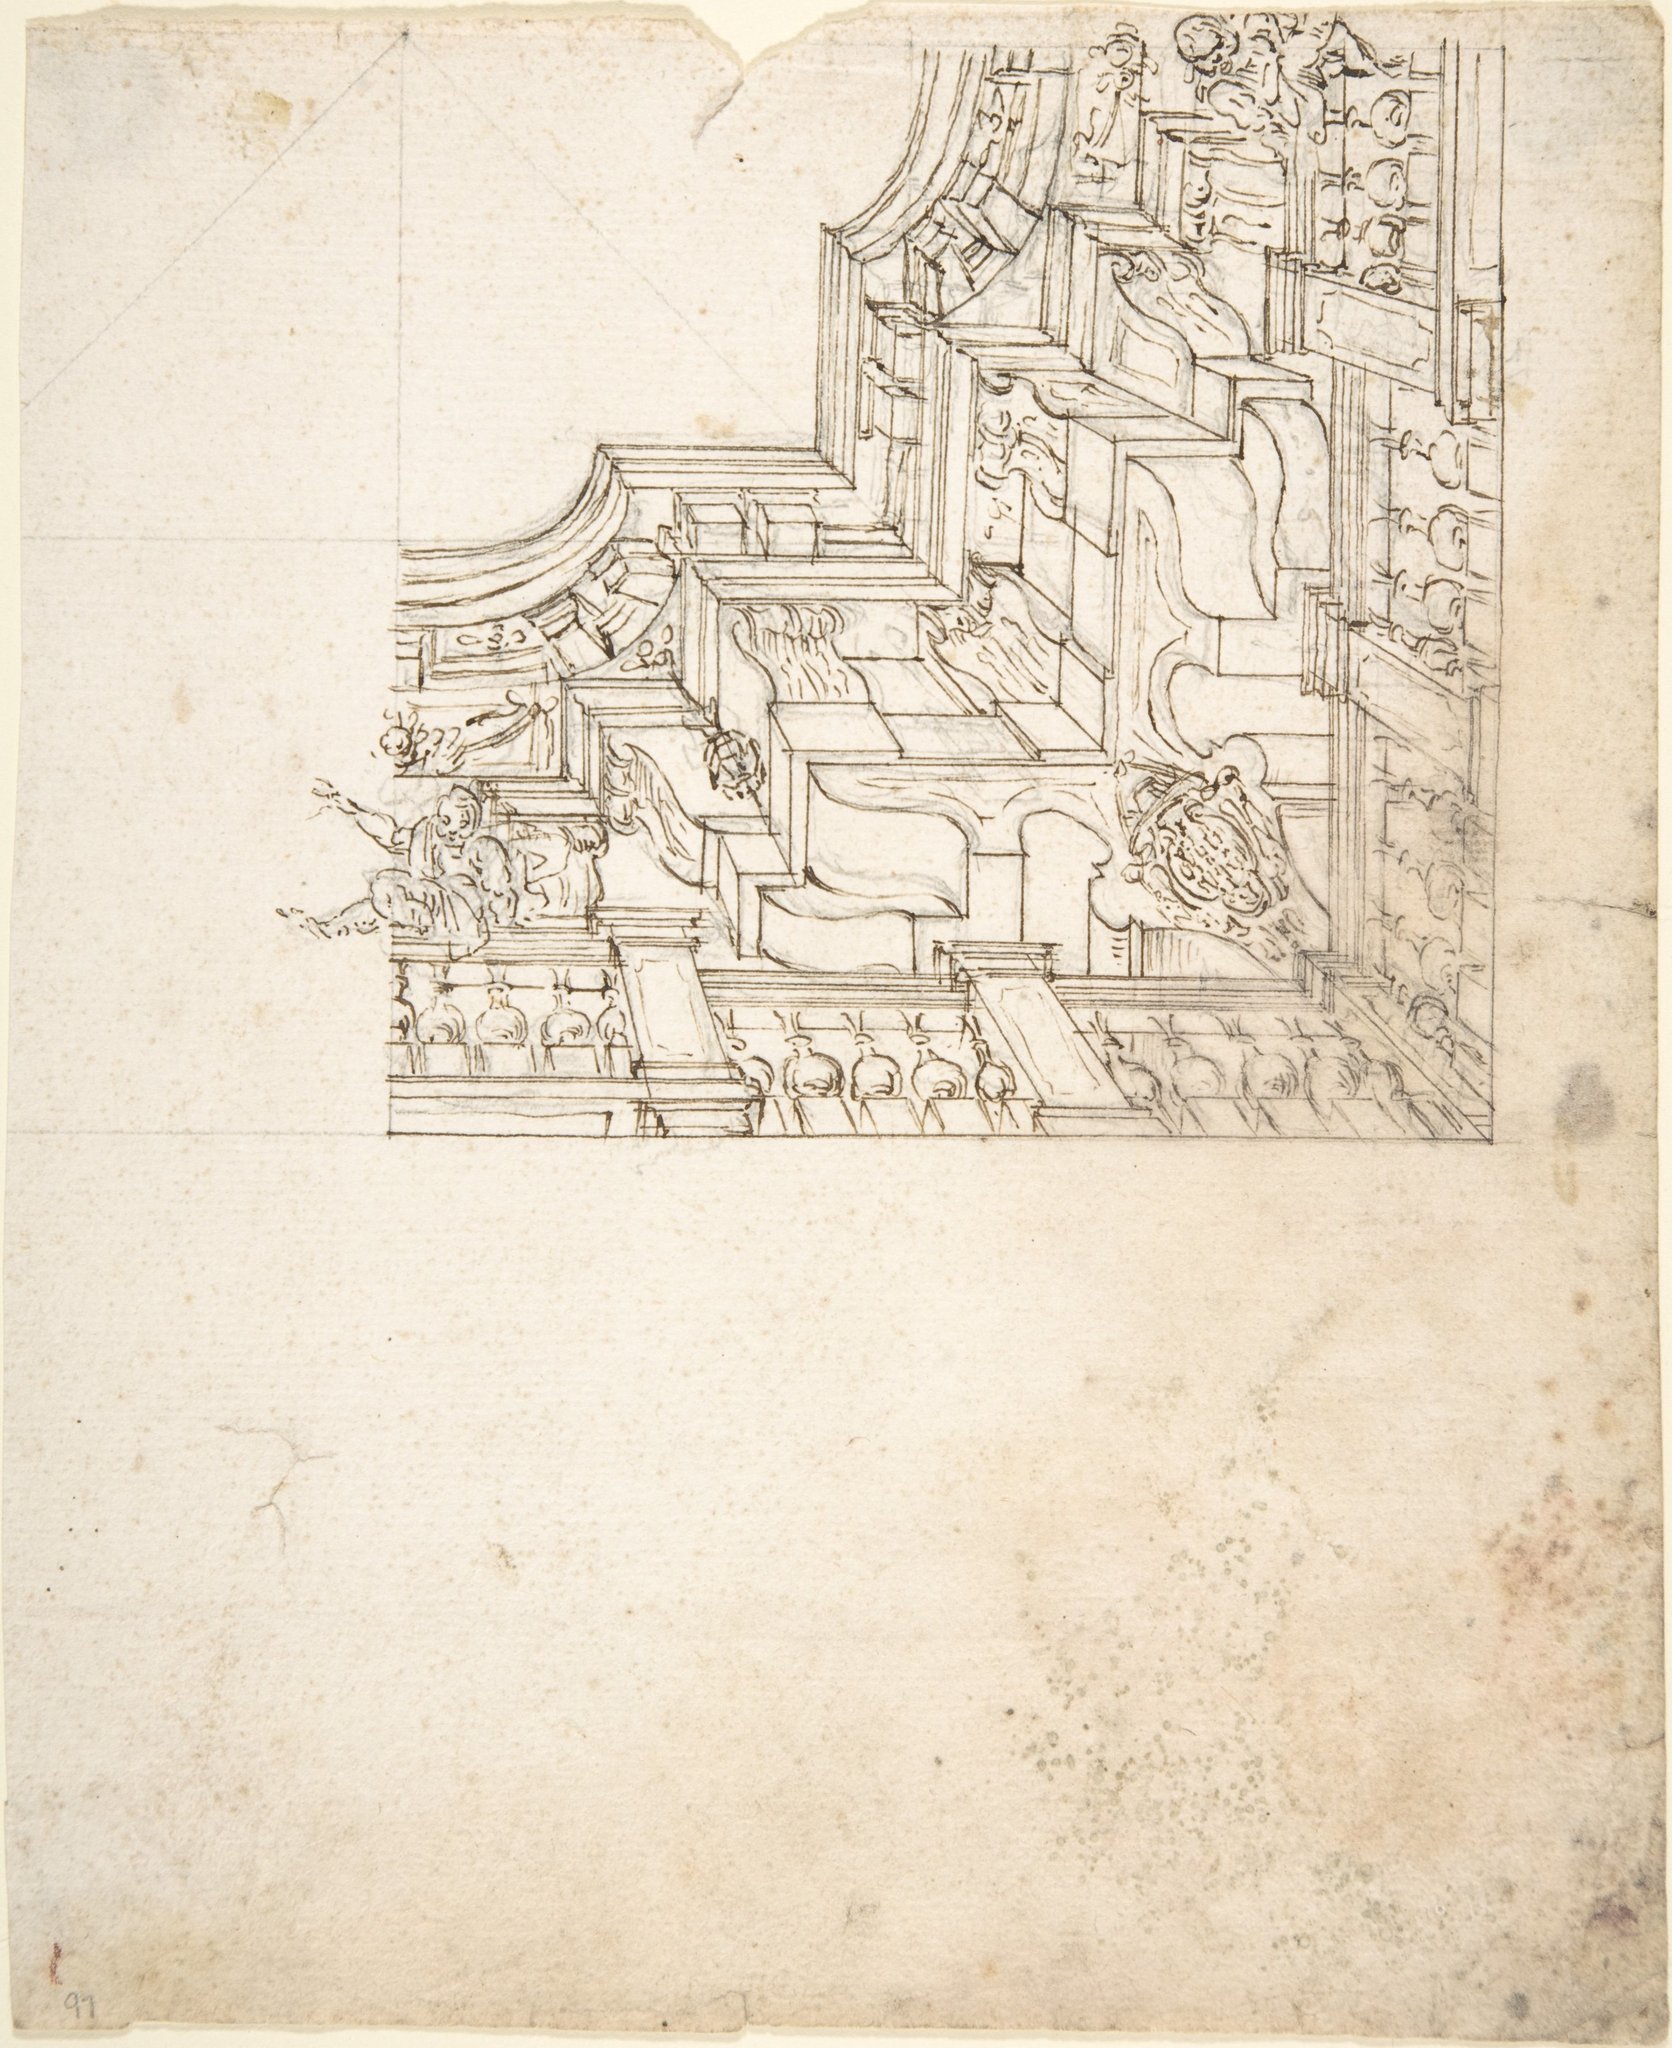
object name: drawing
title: 1/4 Design for a Painted Ceiling, with the Arms of a Cardinal in the Corner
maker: anonymous, italian, piedmontese, 18th century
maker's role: artist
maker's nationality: italian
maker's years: 1700-1800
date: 1700-1780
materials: ink, drawing material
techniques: pen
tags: ceilings